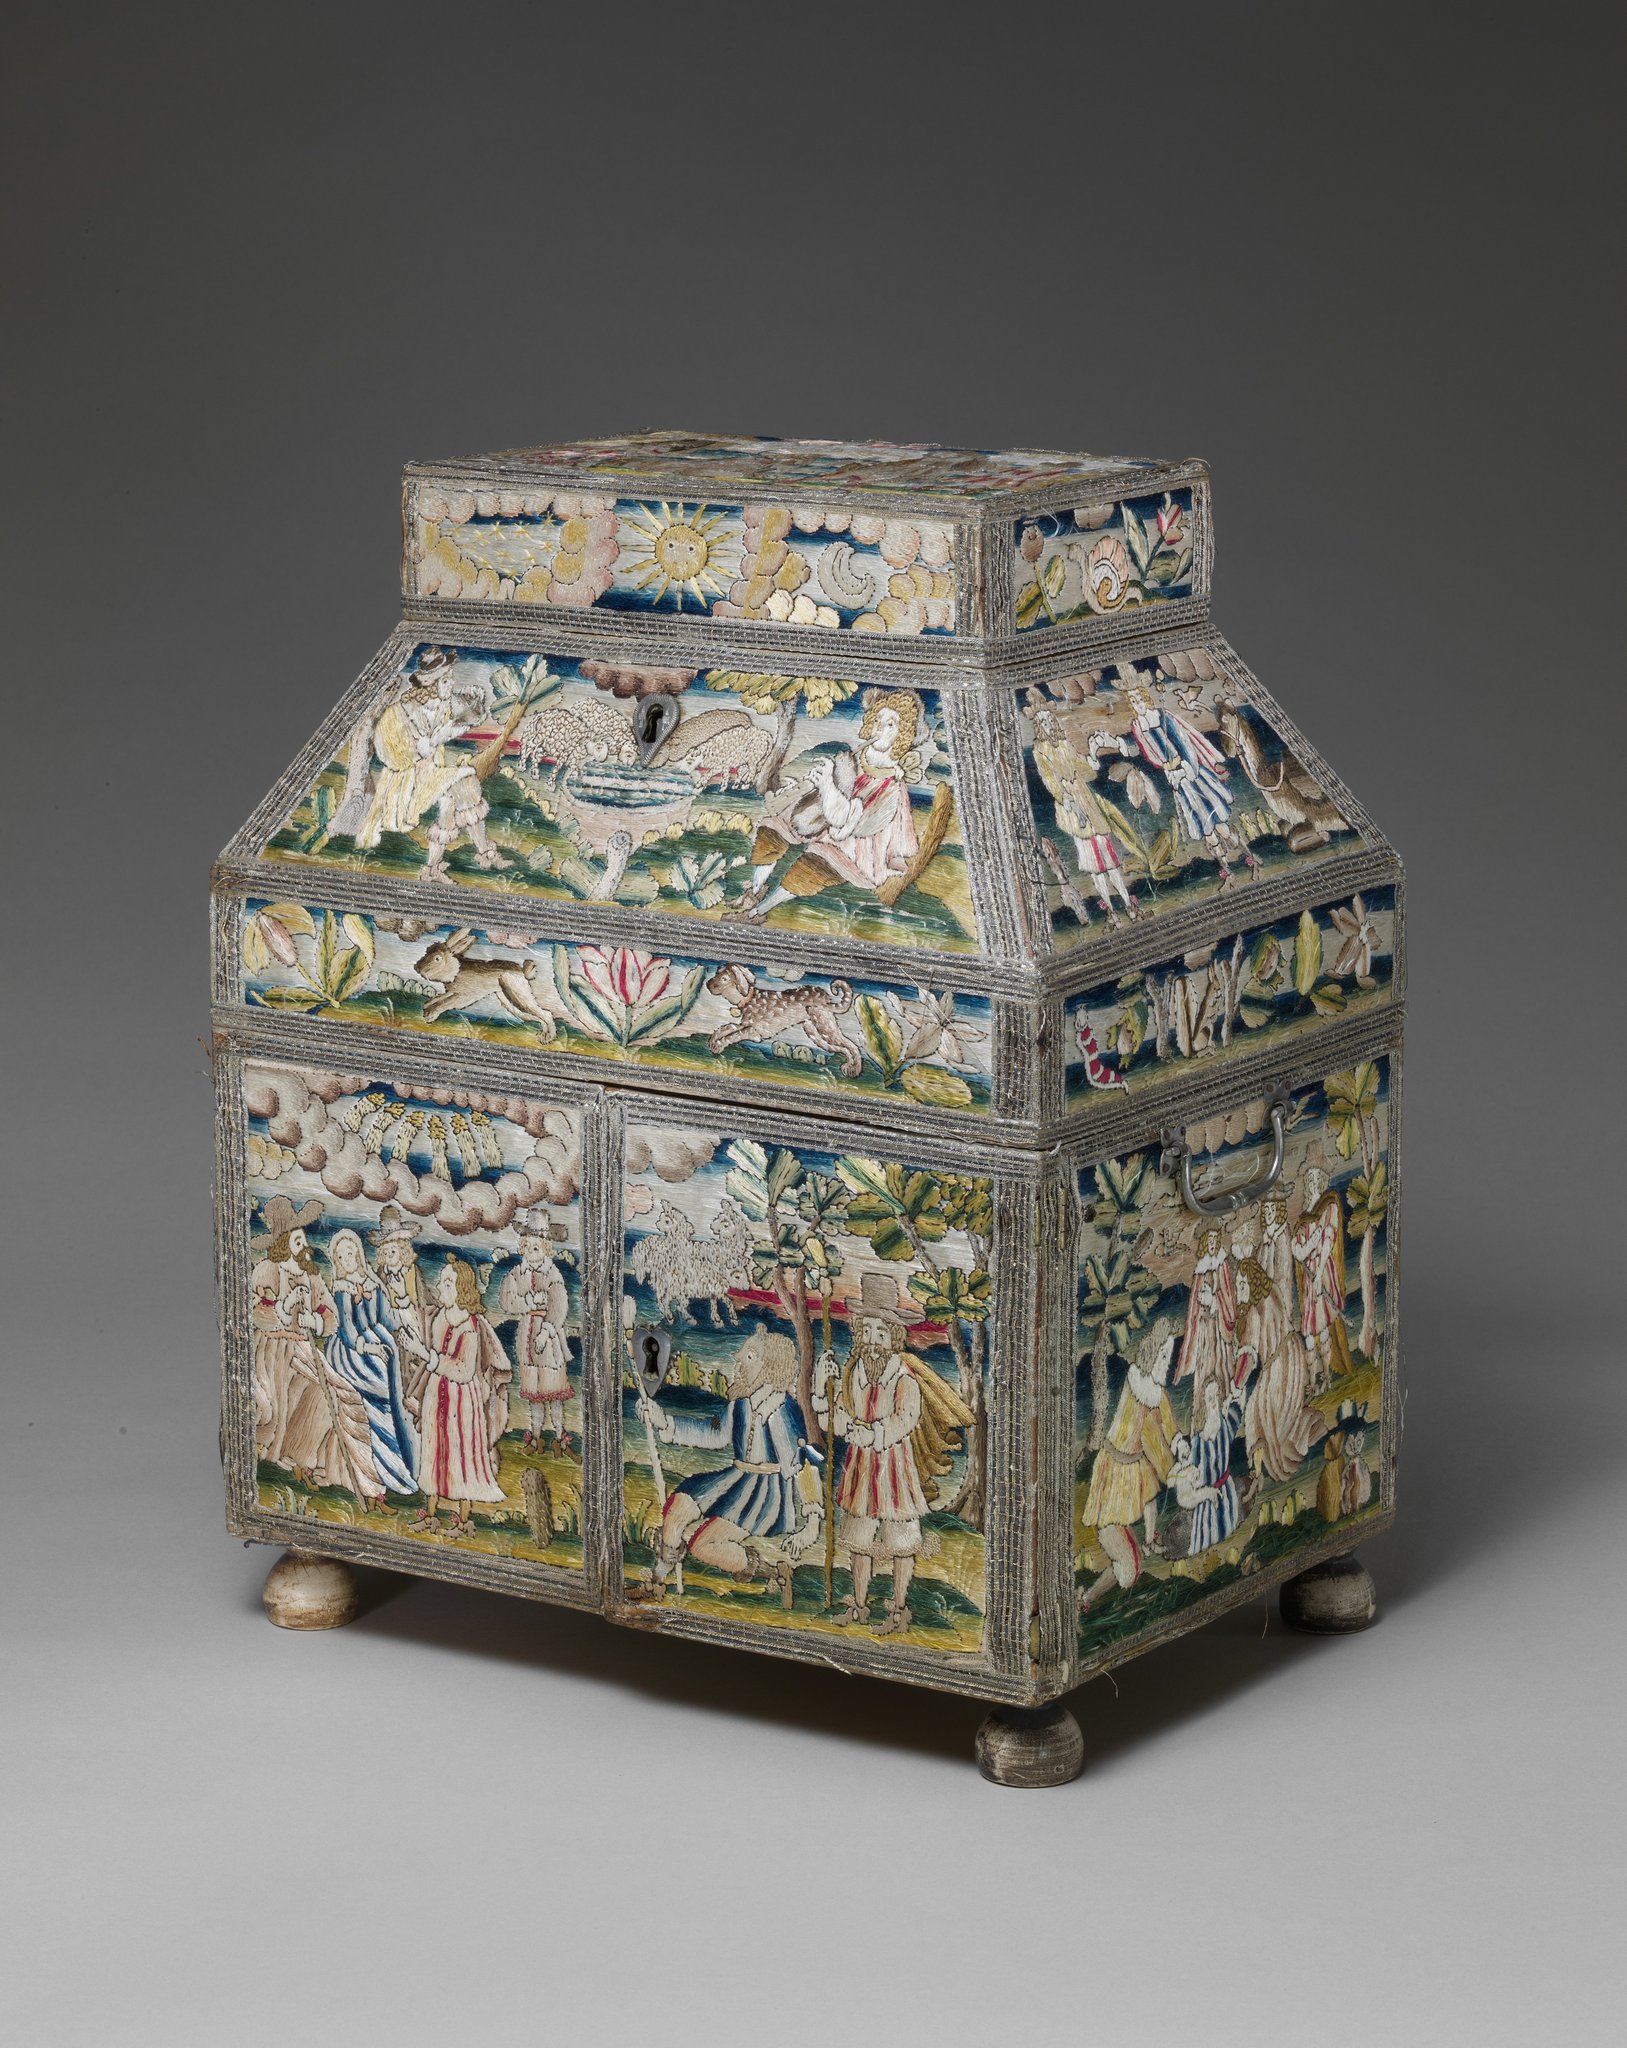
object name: cabinet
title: Cabinet with scenes from the Life of Joseph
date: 1651-1675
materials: linen, metal thread, textile, silk, thread, wood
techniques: laid work, lining, stitching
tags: men,women,dogs,insects,rabbits,sheep